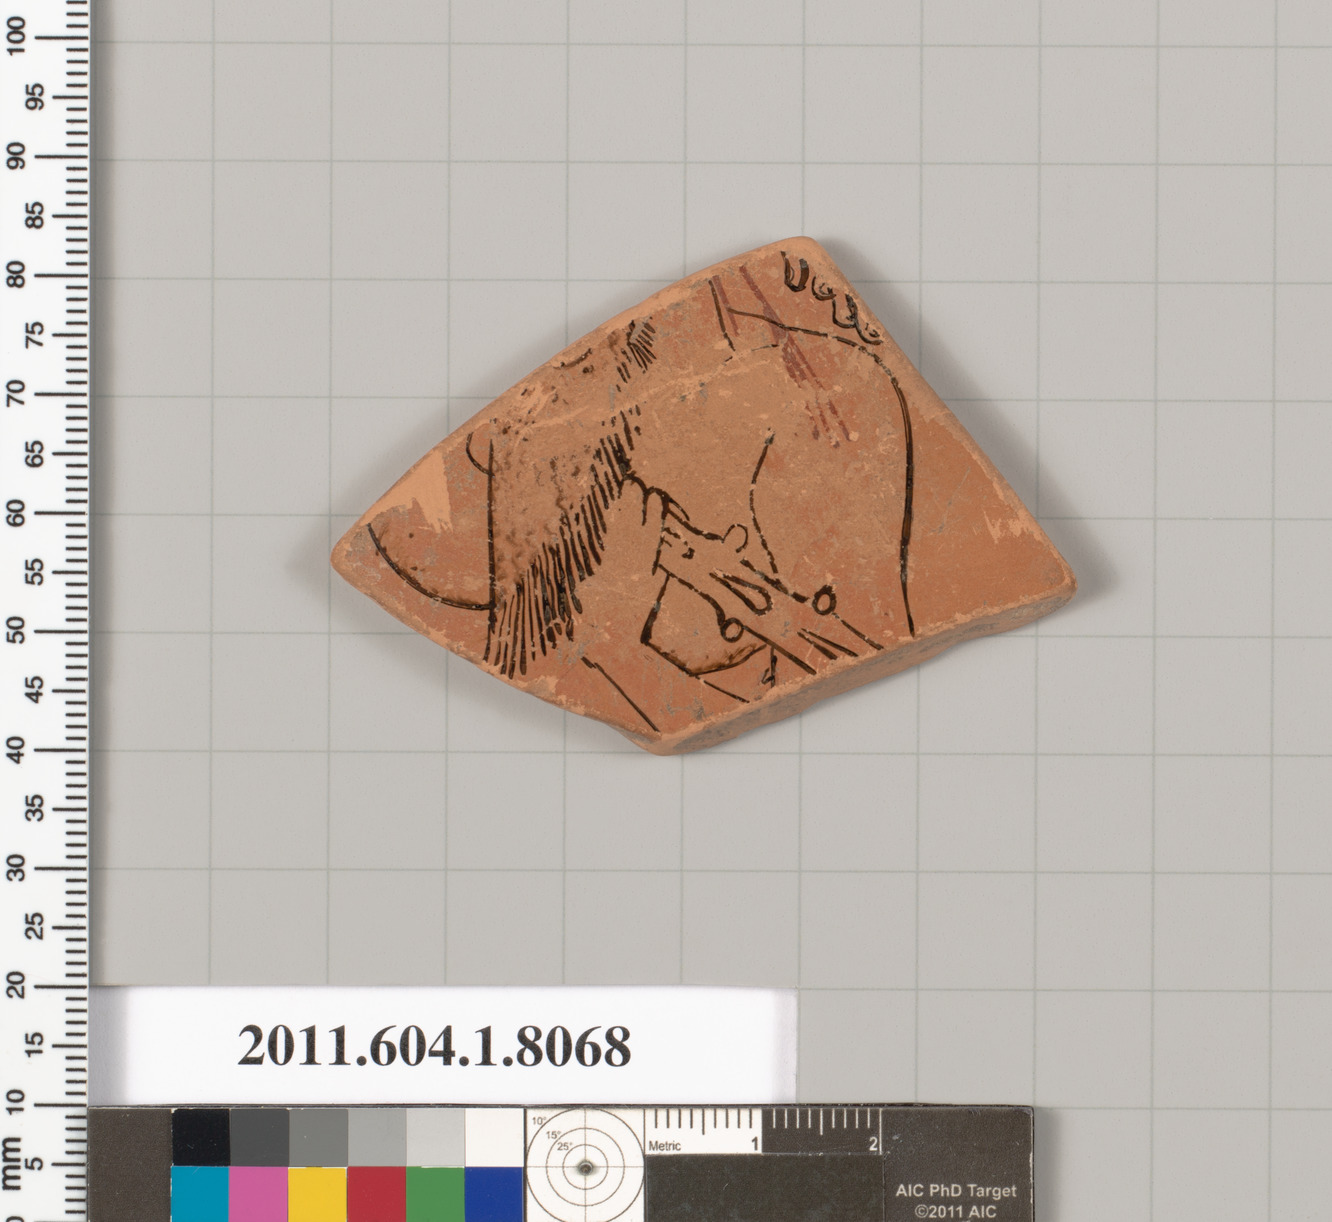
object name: kylix fragment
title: Terracotta fragment of a kylix (drinking cup)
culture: greek, attic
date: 510-490 BCE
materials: terracotta